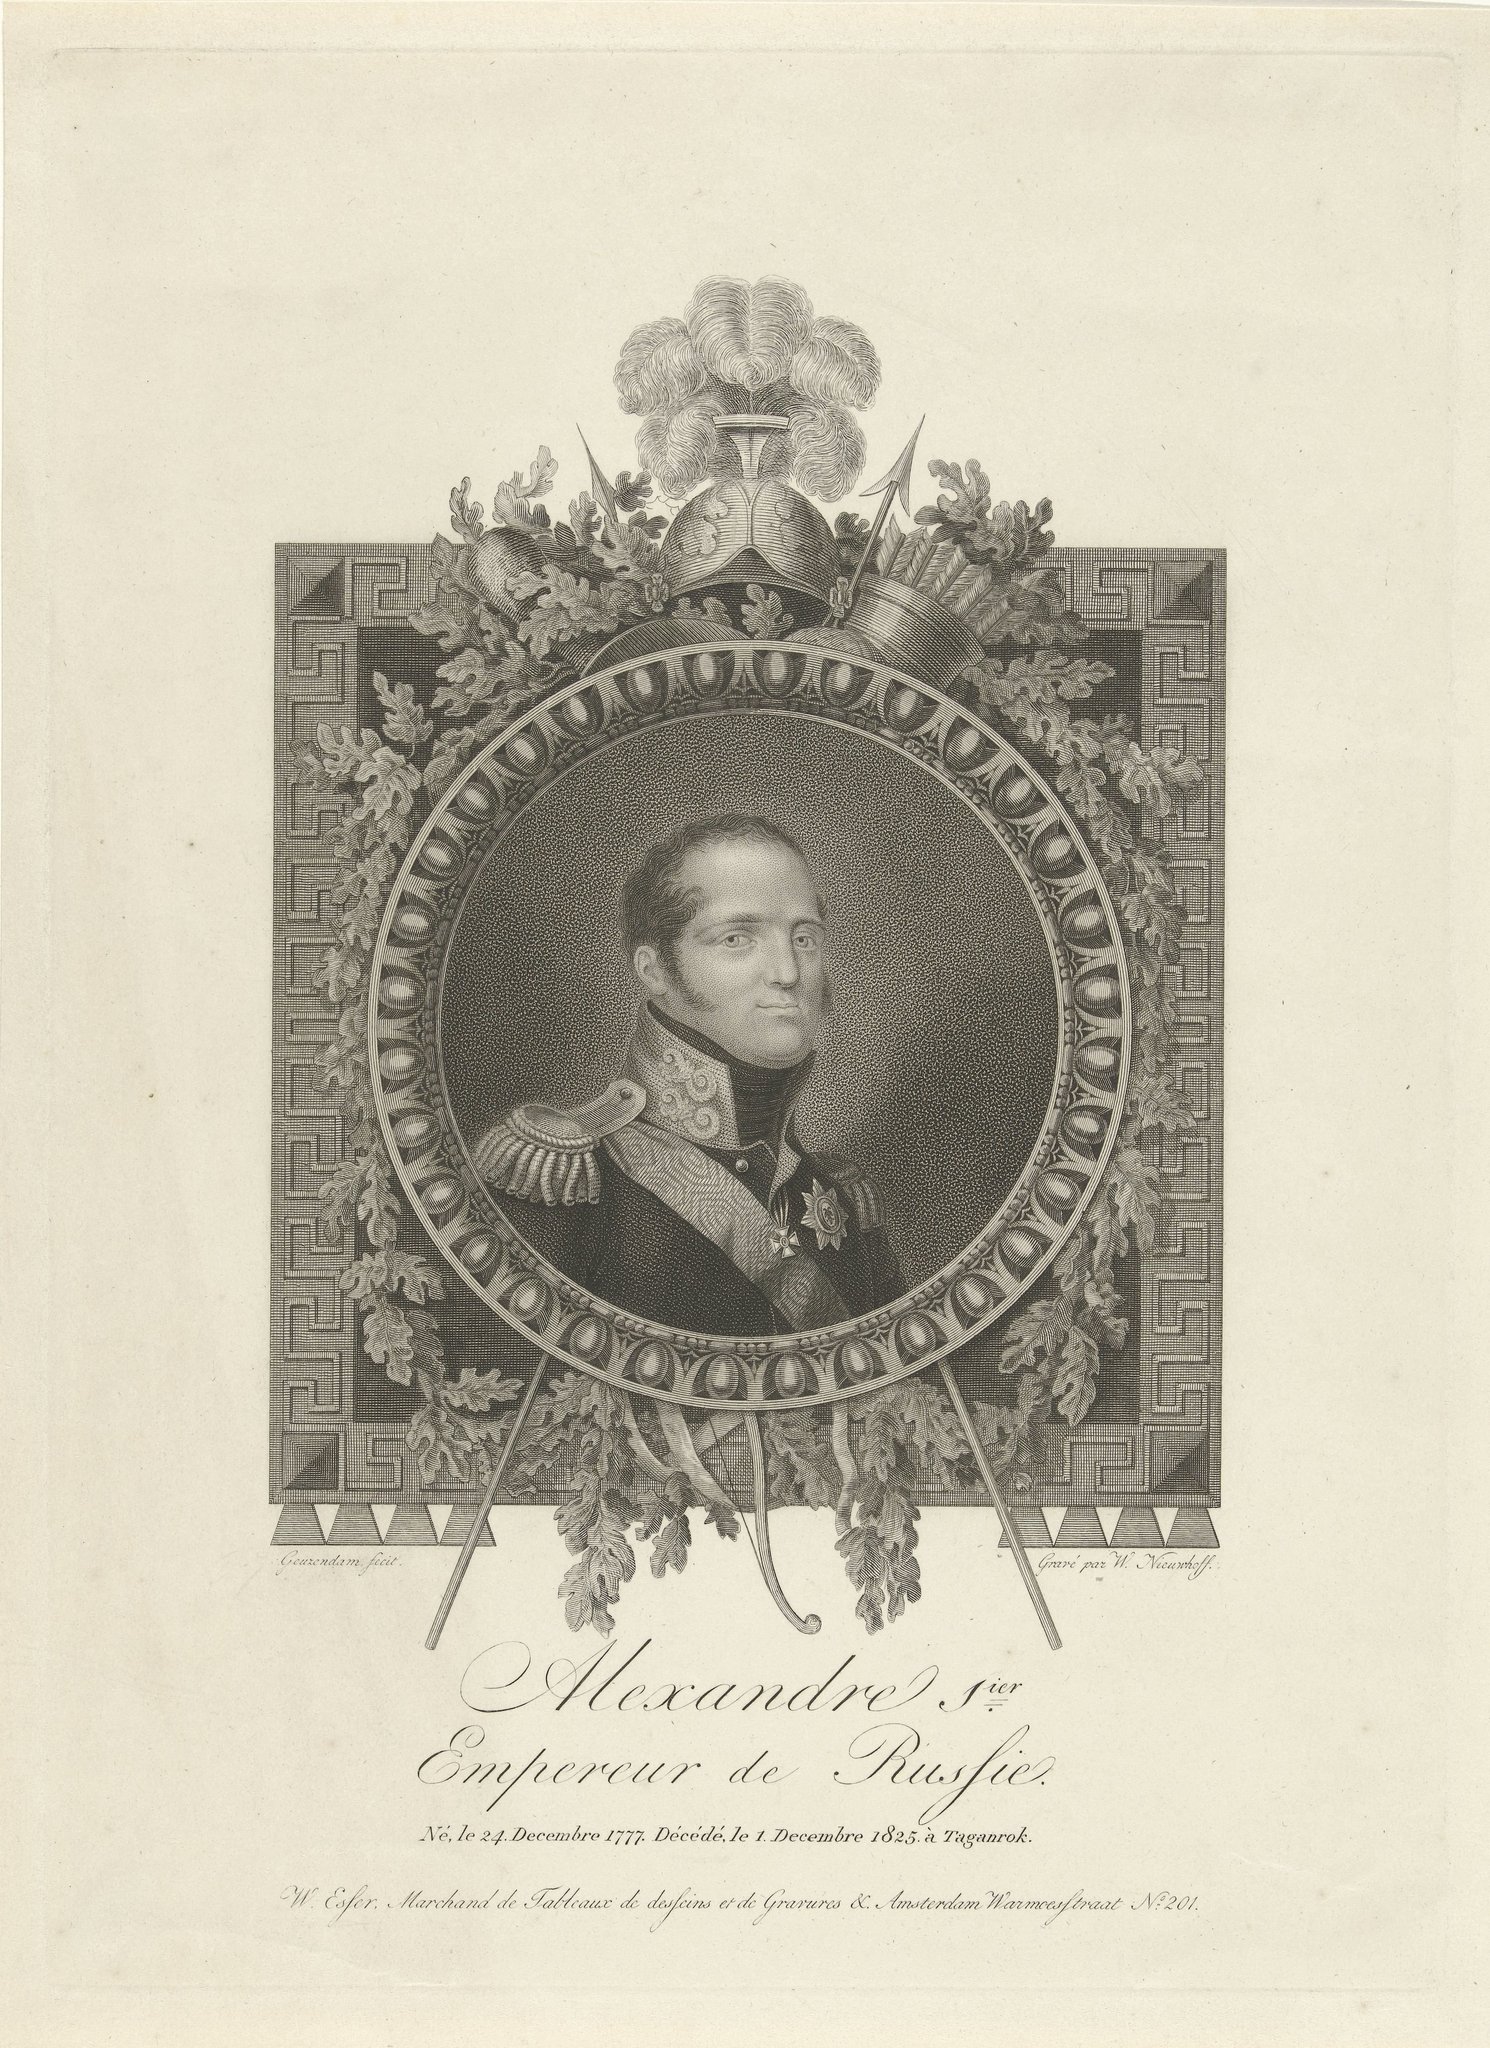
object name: print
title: Portret van tsaar Alexander I van Rusland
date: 1825-1827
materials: paper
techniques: engraving, etching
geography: amsterdam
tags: alexander i (tsaar van rusland), helmet, archer's weapons: bow and arrow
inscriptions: collector's mark: Lugt 2228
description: Portret van Alexander I, tsaar van Rusland, gekleed in een jas met ringkraag, epauletten en een sjerp. Buste naar rechts in een cirkelvormige lijst. De lijst wordt bekroond met een helm. In de randversiering zijn pijlen, een pijlenkoker en een boog verwerkt. Onderaan in de marge de titel, geboorte- en sterfdata van tsaar Alexander I in het Frans.